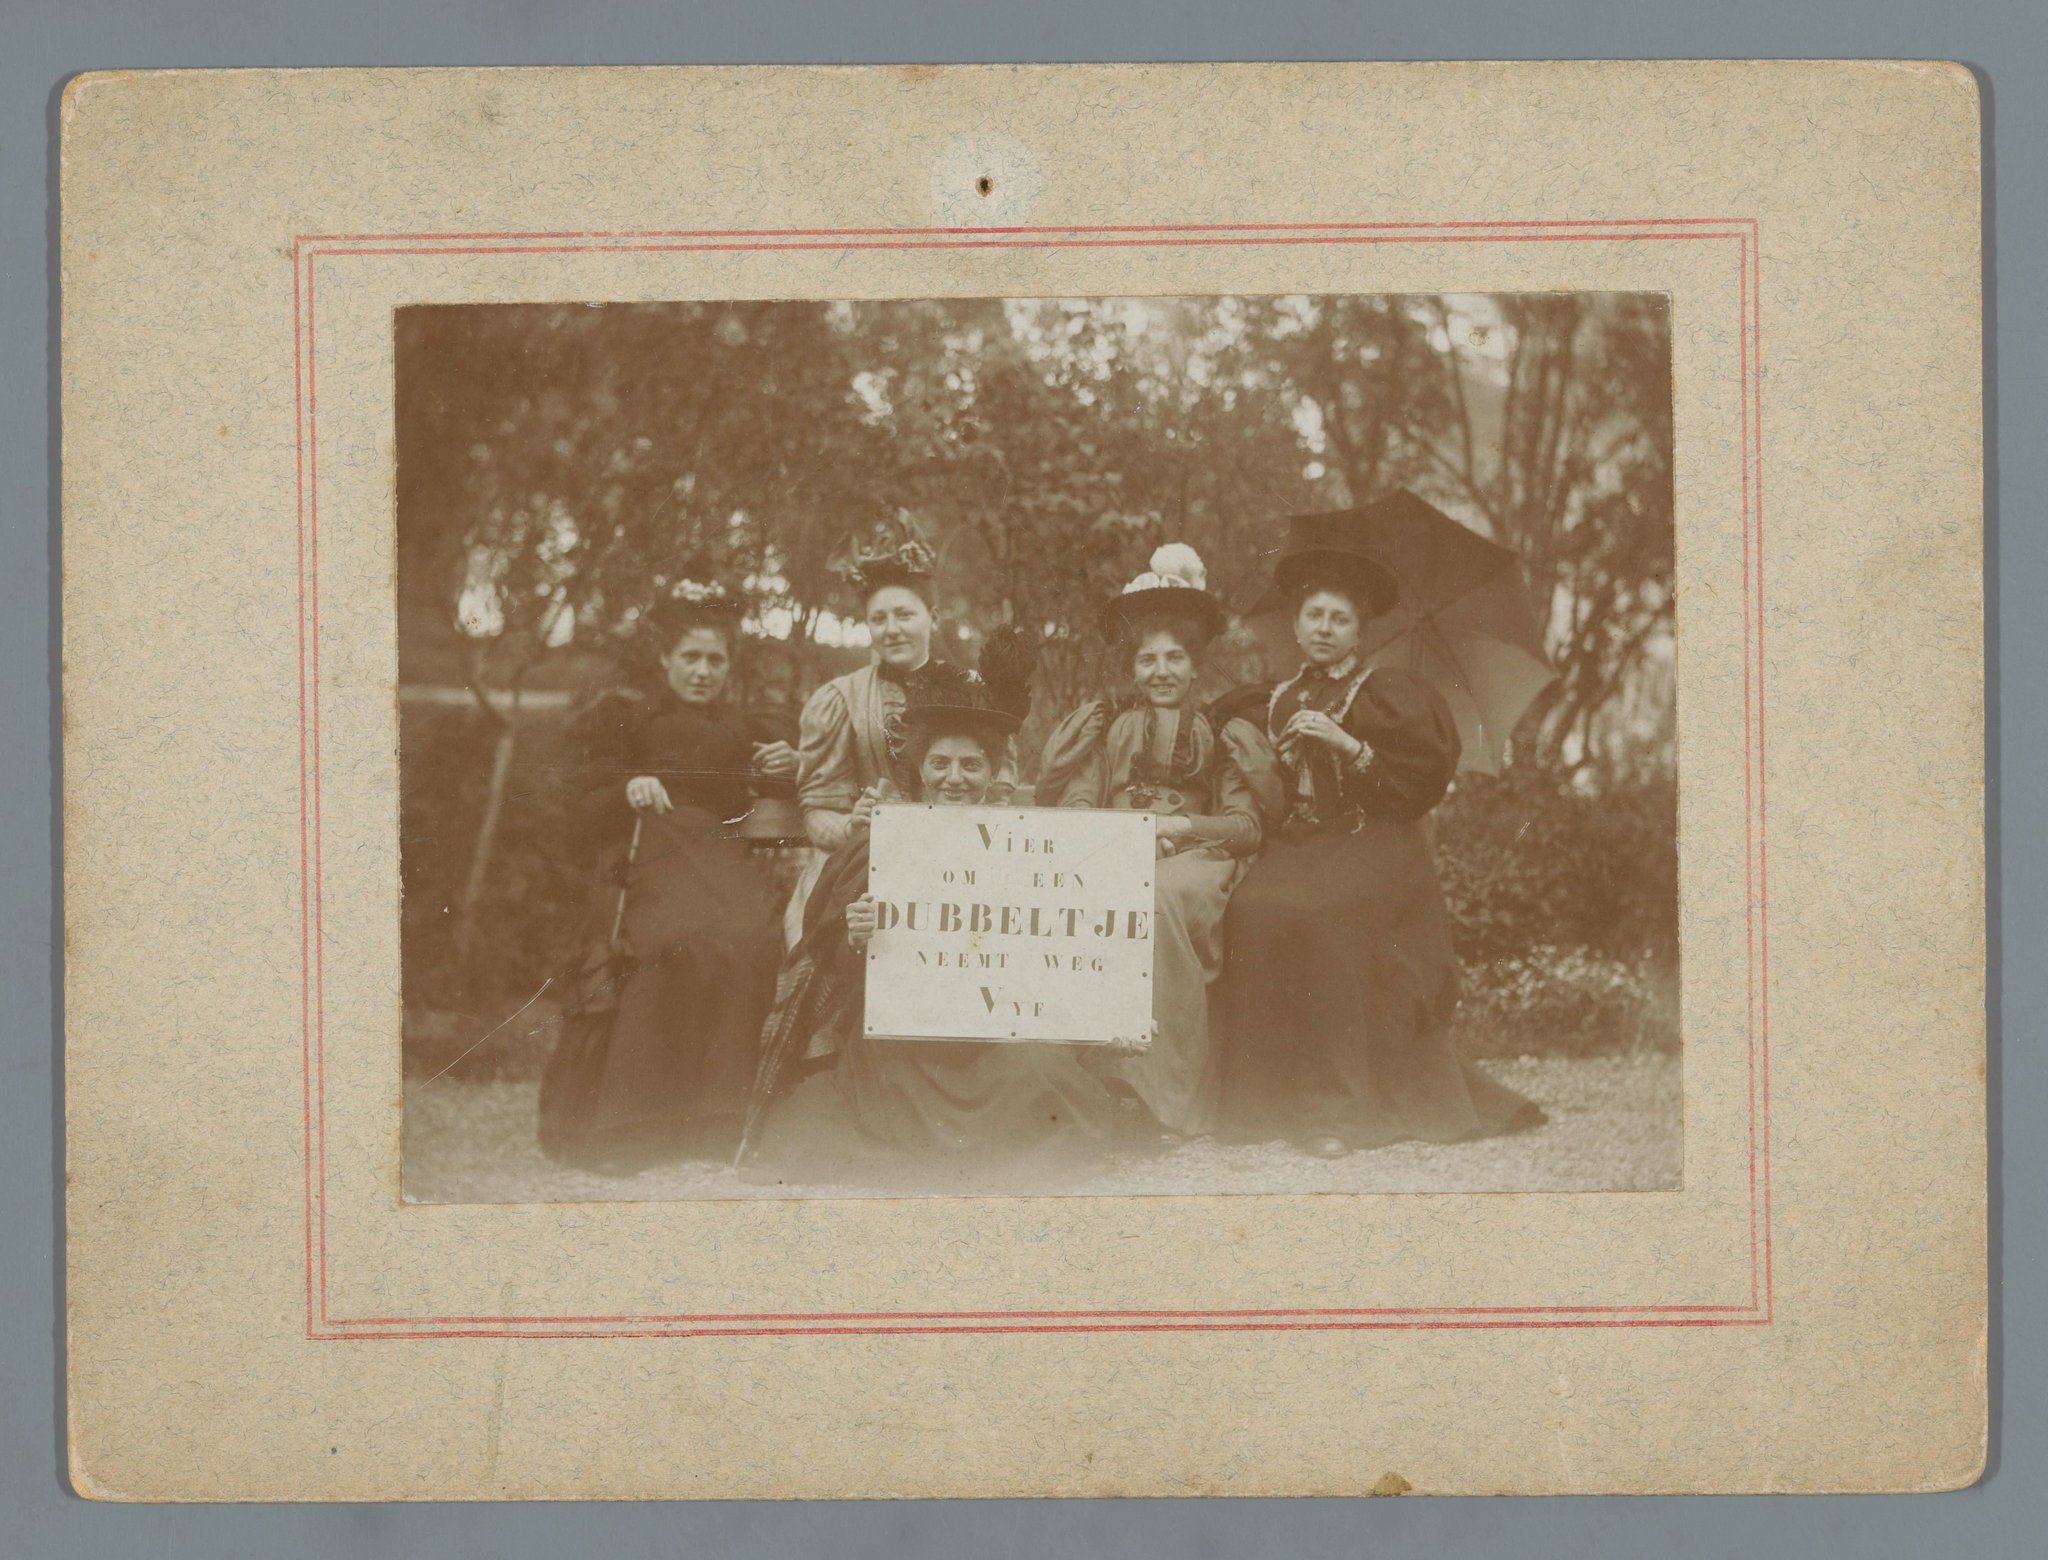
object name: photograph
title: Groepsportret van Wilhelmina Gerarda Hoogendijk met (vermoedelijk) vier familieleden op een bank in (vermoedelijk) een park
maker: Anonymous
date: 1900-1905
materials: cardboard, photographic support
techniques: collodion silver print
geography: netherlands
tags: bench, public gardens, park, anonymous historical persons portrayed in a group, in a group-portrait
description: De vijf vrouwen zijn gepositioneerd rond een bord met de tekst 'Vier om een dubbeltje neemt weg vyf".